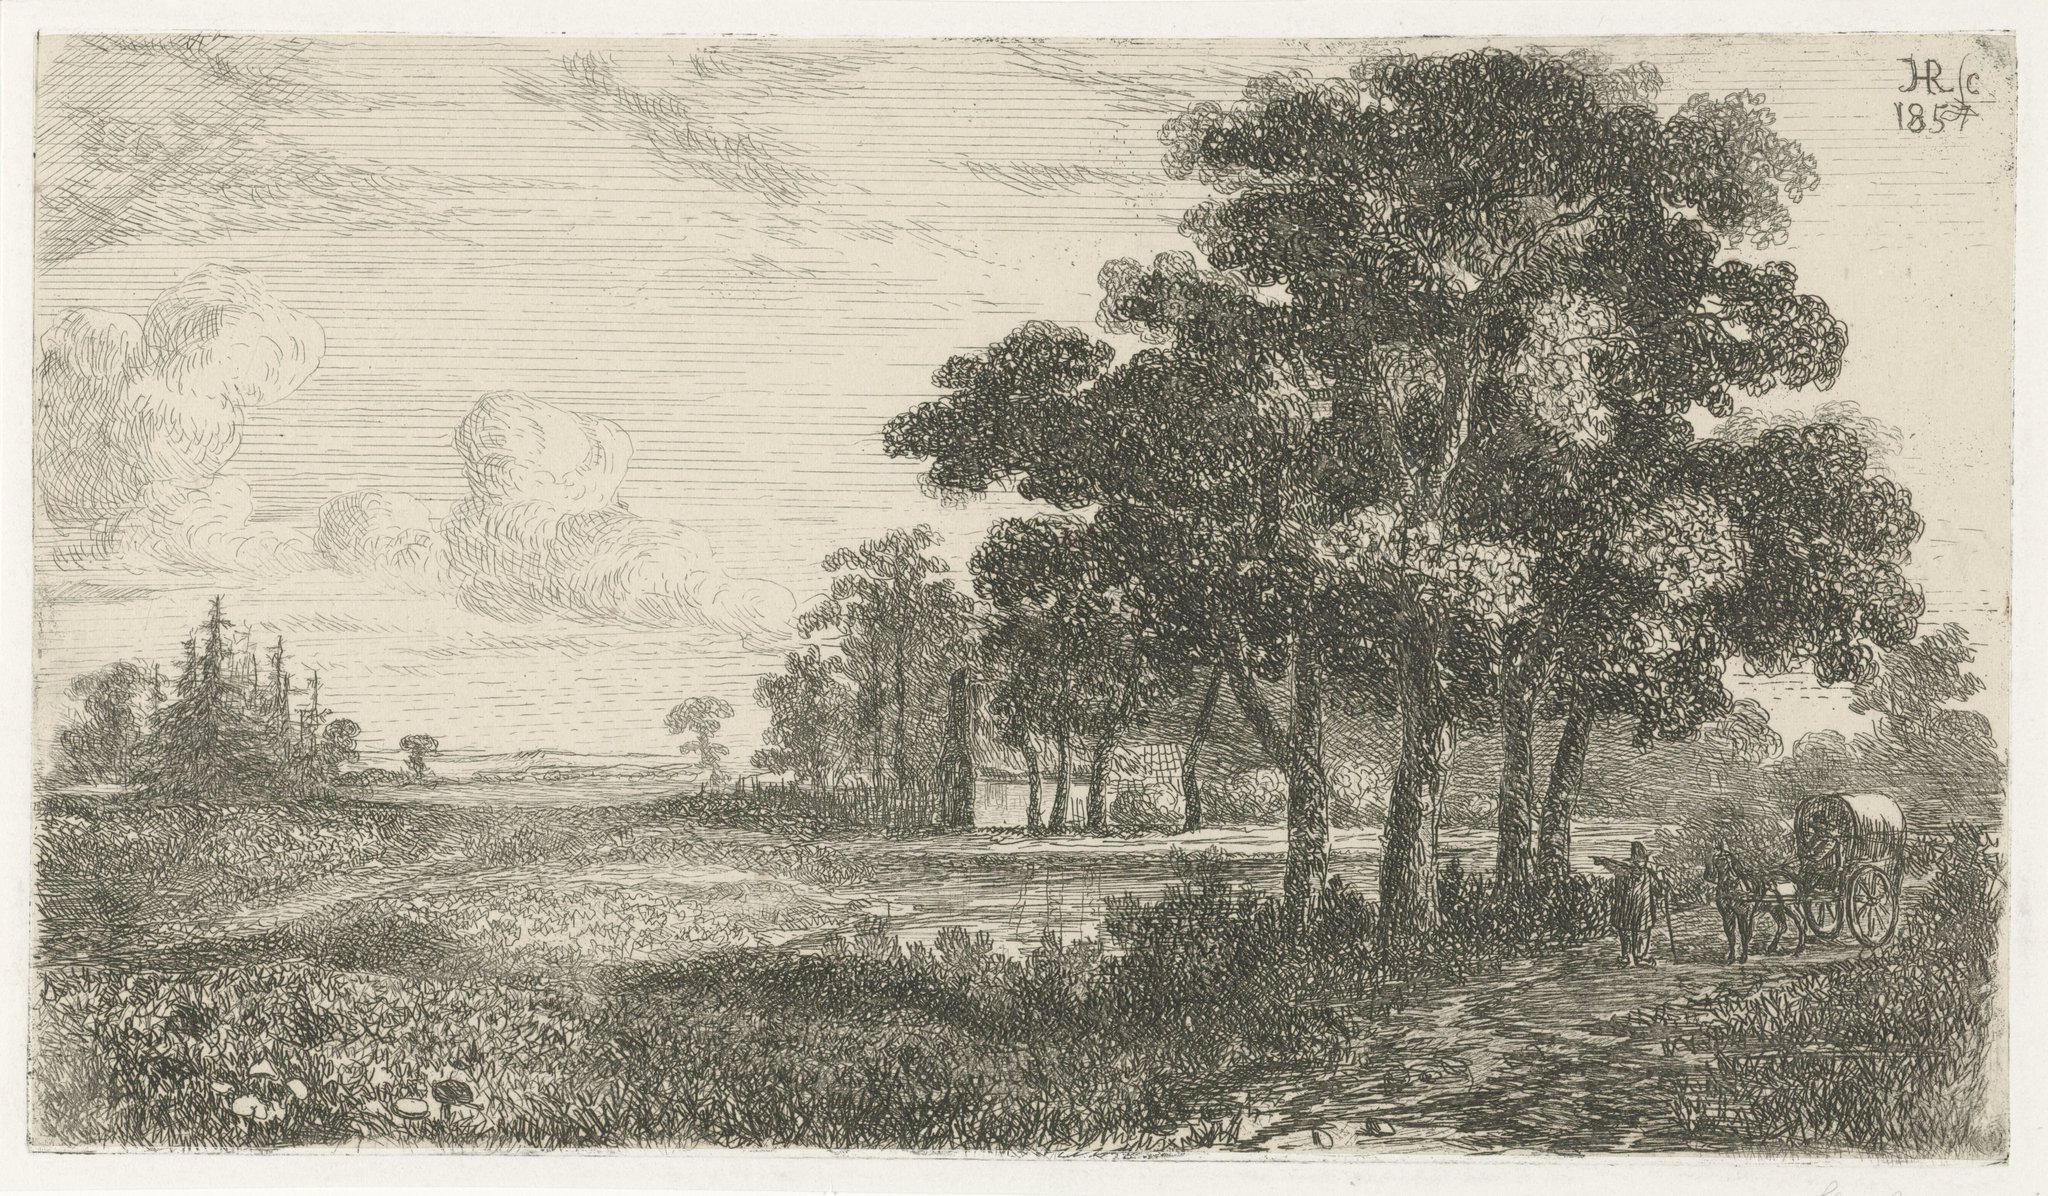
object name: print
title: Boomrijk landschap met huifkar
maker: hermanus jan hendrik van rijkelijkhuysen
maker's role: painter, print maker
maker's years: 1813-1883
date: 1857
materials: paper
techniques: drypoint, etching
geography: utrecht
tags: trees, fen, du. 'ven', 'en route', traveller under way, farm or solitary house in landscape, (farm) wagon, freight wagon, cart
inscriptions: collector's mark: Lugt 2228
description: Een ven in een boomrijk landschap, met rechts een wandelaar en een huifkar. Op de achtergrond een boerenhoeve.